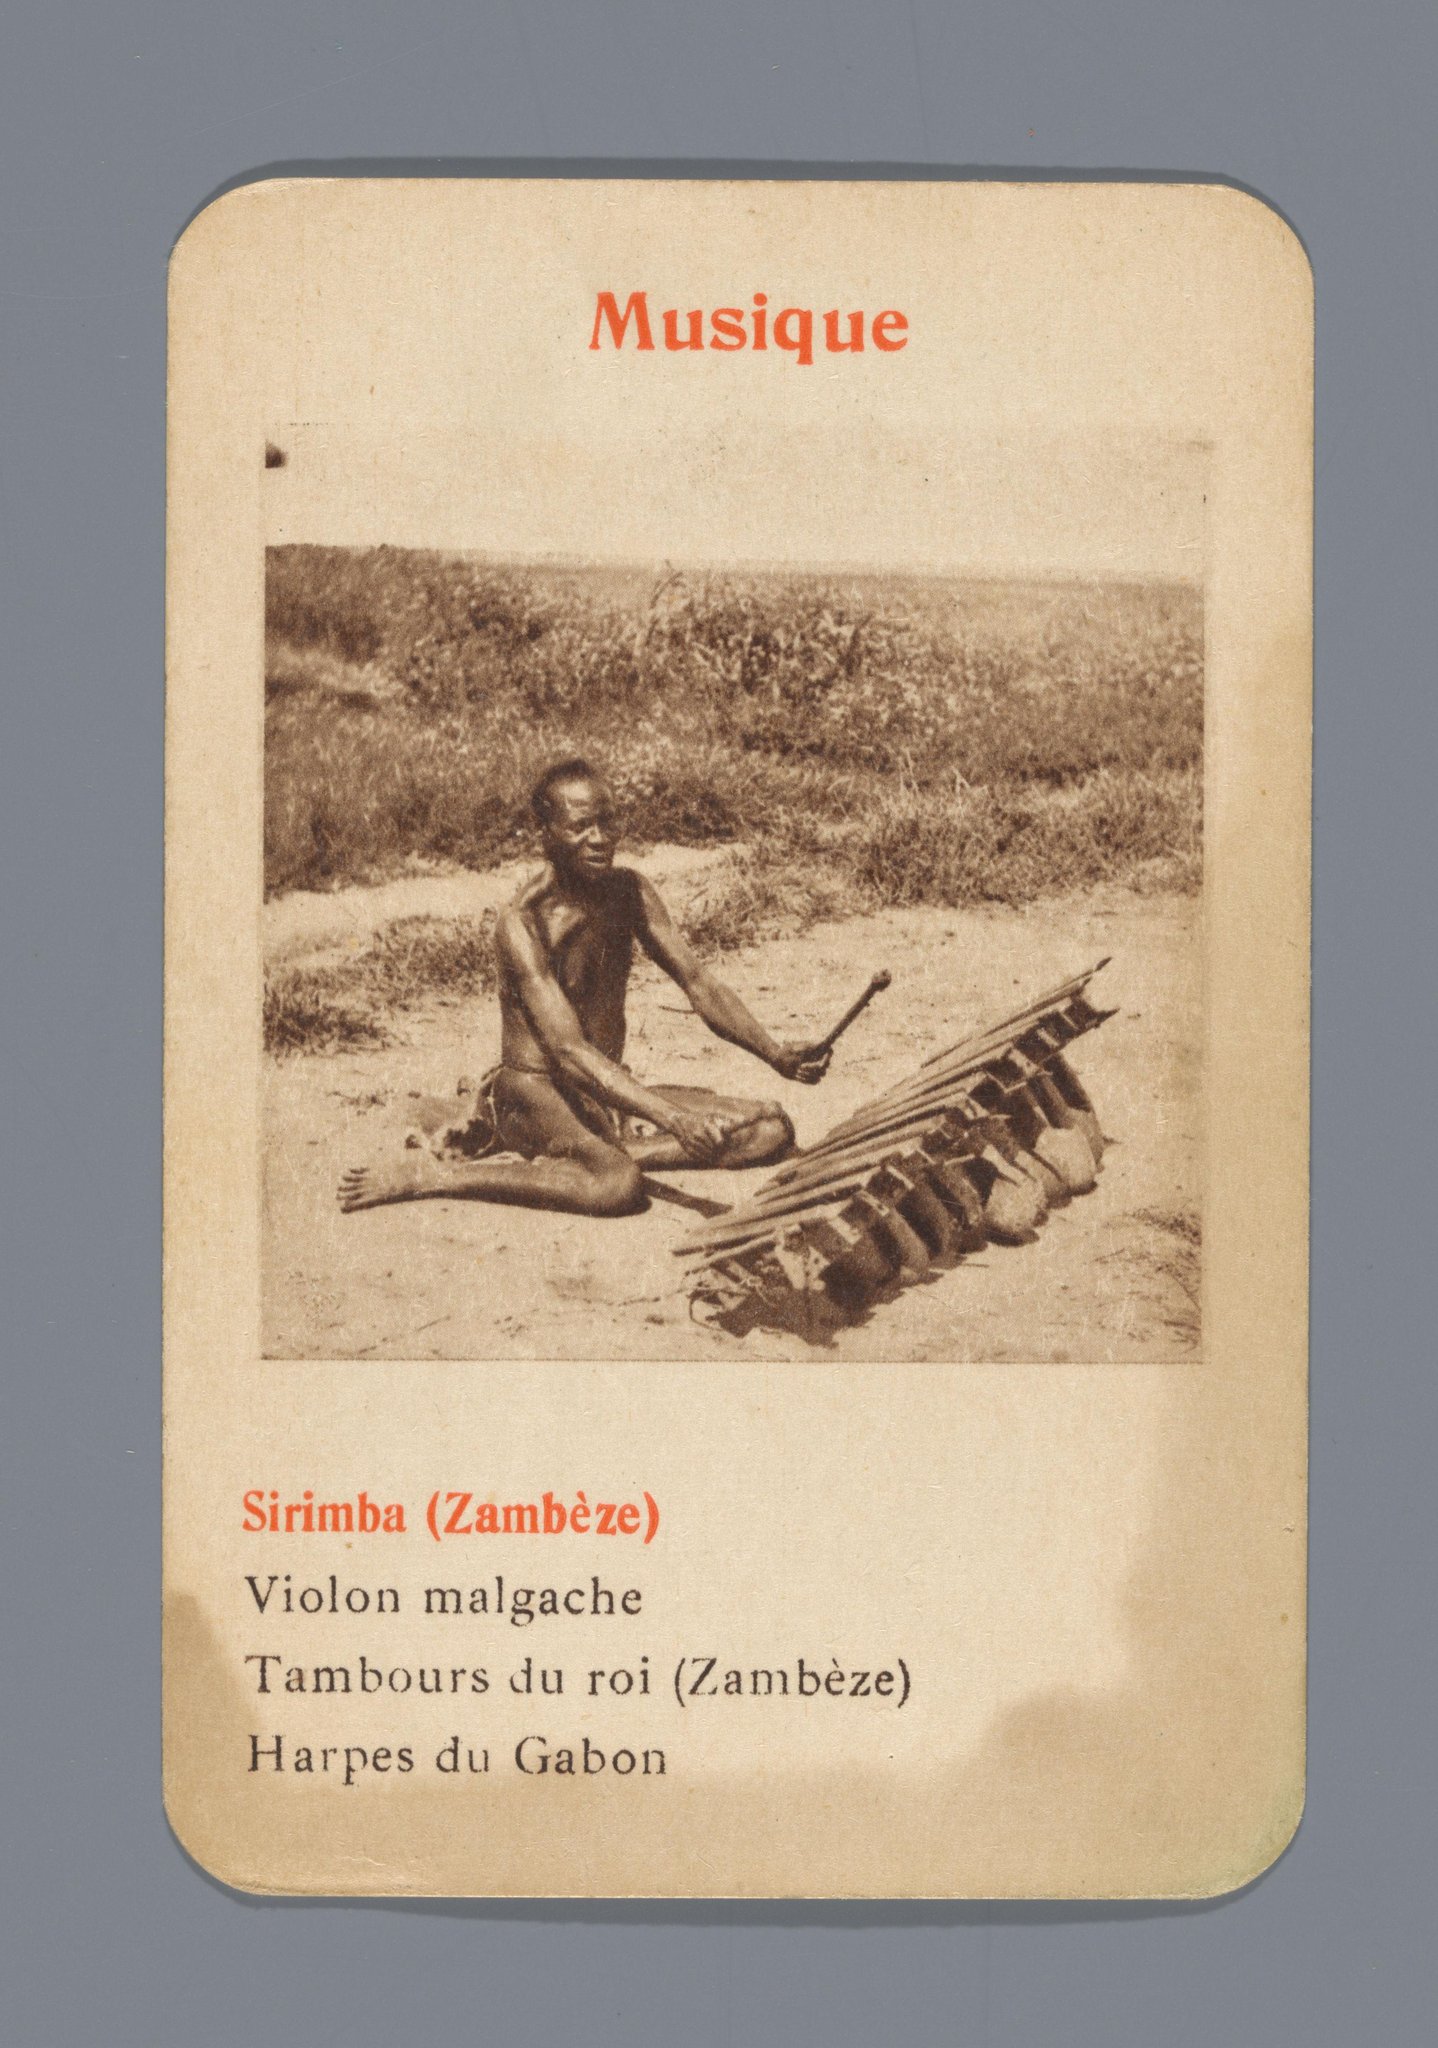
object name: photomechanical print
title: Sirimba (Zambèze)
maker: Anonymous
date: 1900-1920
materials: cardboard, paper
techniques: rotogravure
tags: other percussion instruments, card games